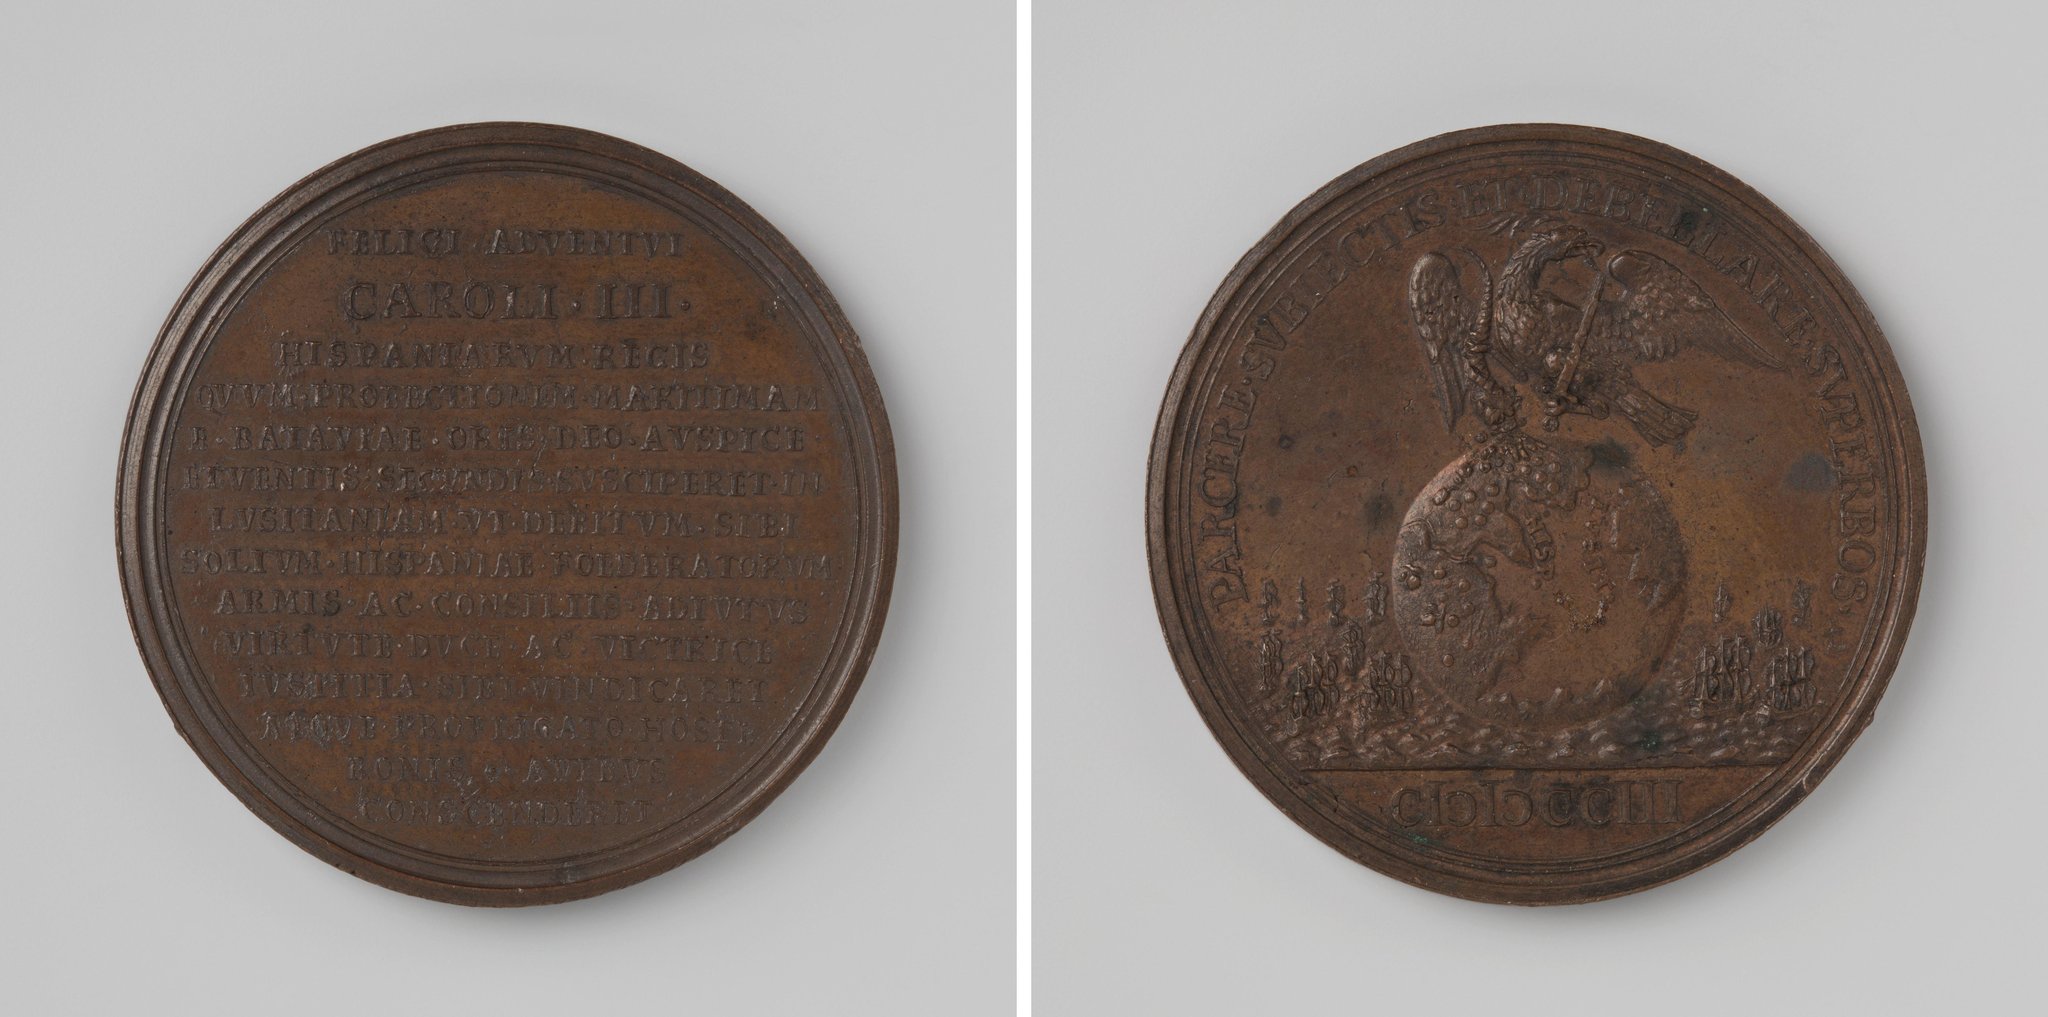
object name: history medal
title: Aankomst van Karel III, koning van Spanje in Portugal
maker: Anonymous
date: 1704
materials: bronze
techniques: striking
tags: vienna, charles vi (holy roman emperor), spain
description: Bronzen penning. Voorzijde: opschrift. Keerzijde: keizerlijke arend met palmtak in bek en zwaard in klauw giet hoorn van overvloed leeg over dat gedeelte van wereldbol, dat Spanje en Portugal voorstelt; daaromheen vloot binnen omschrift, boven opschrift